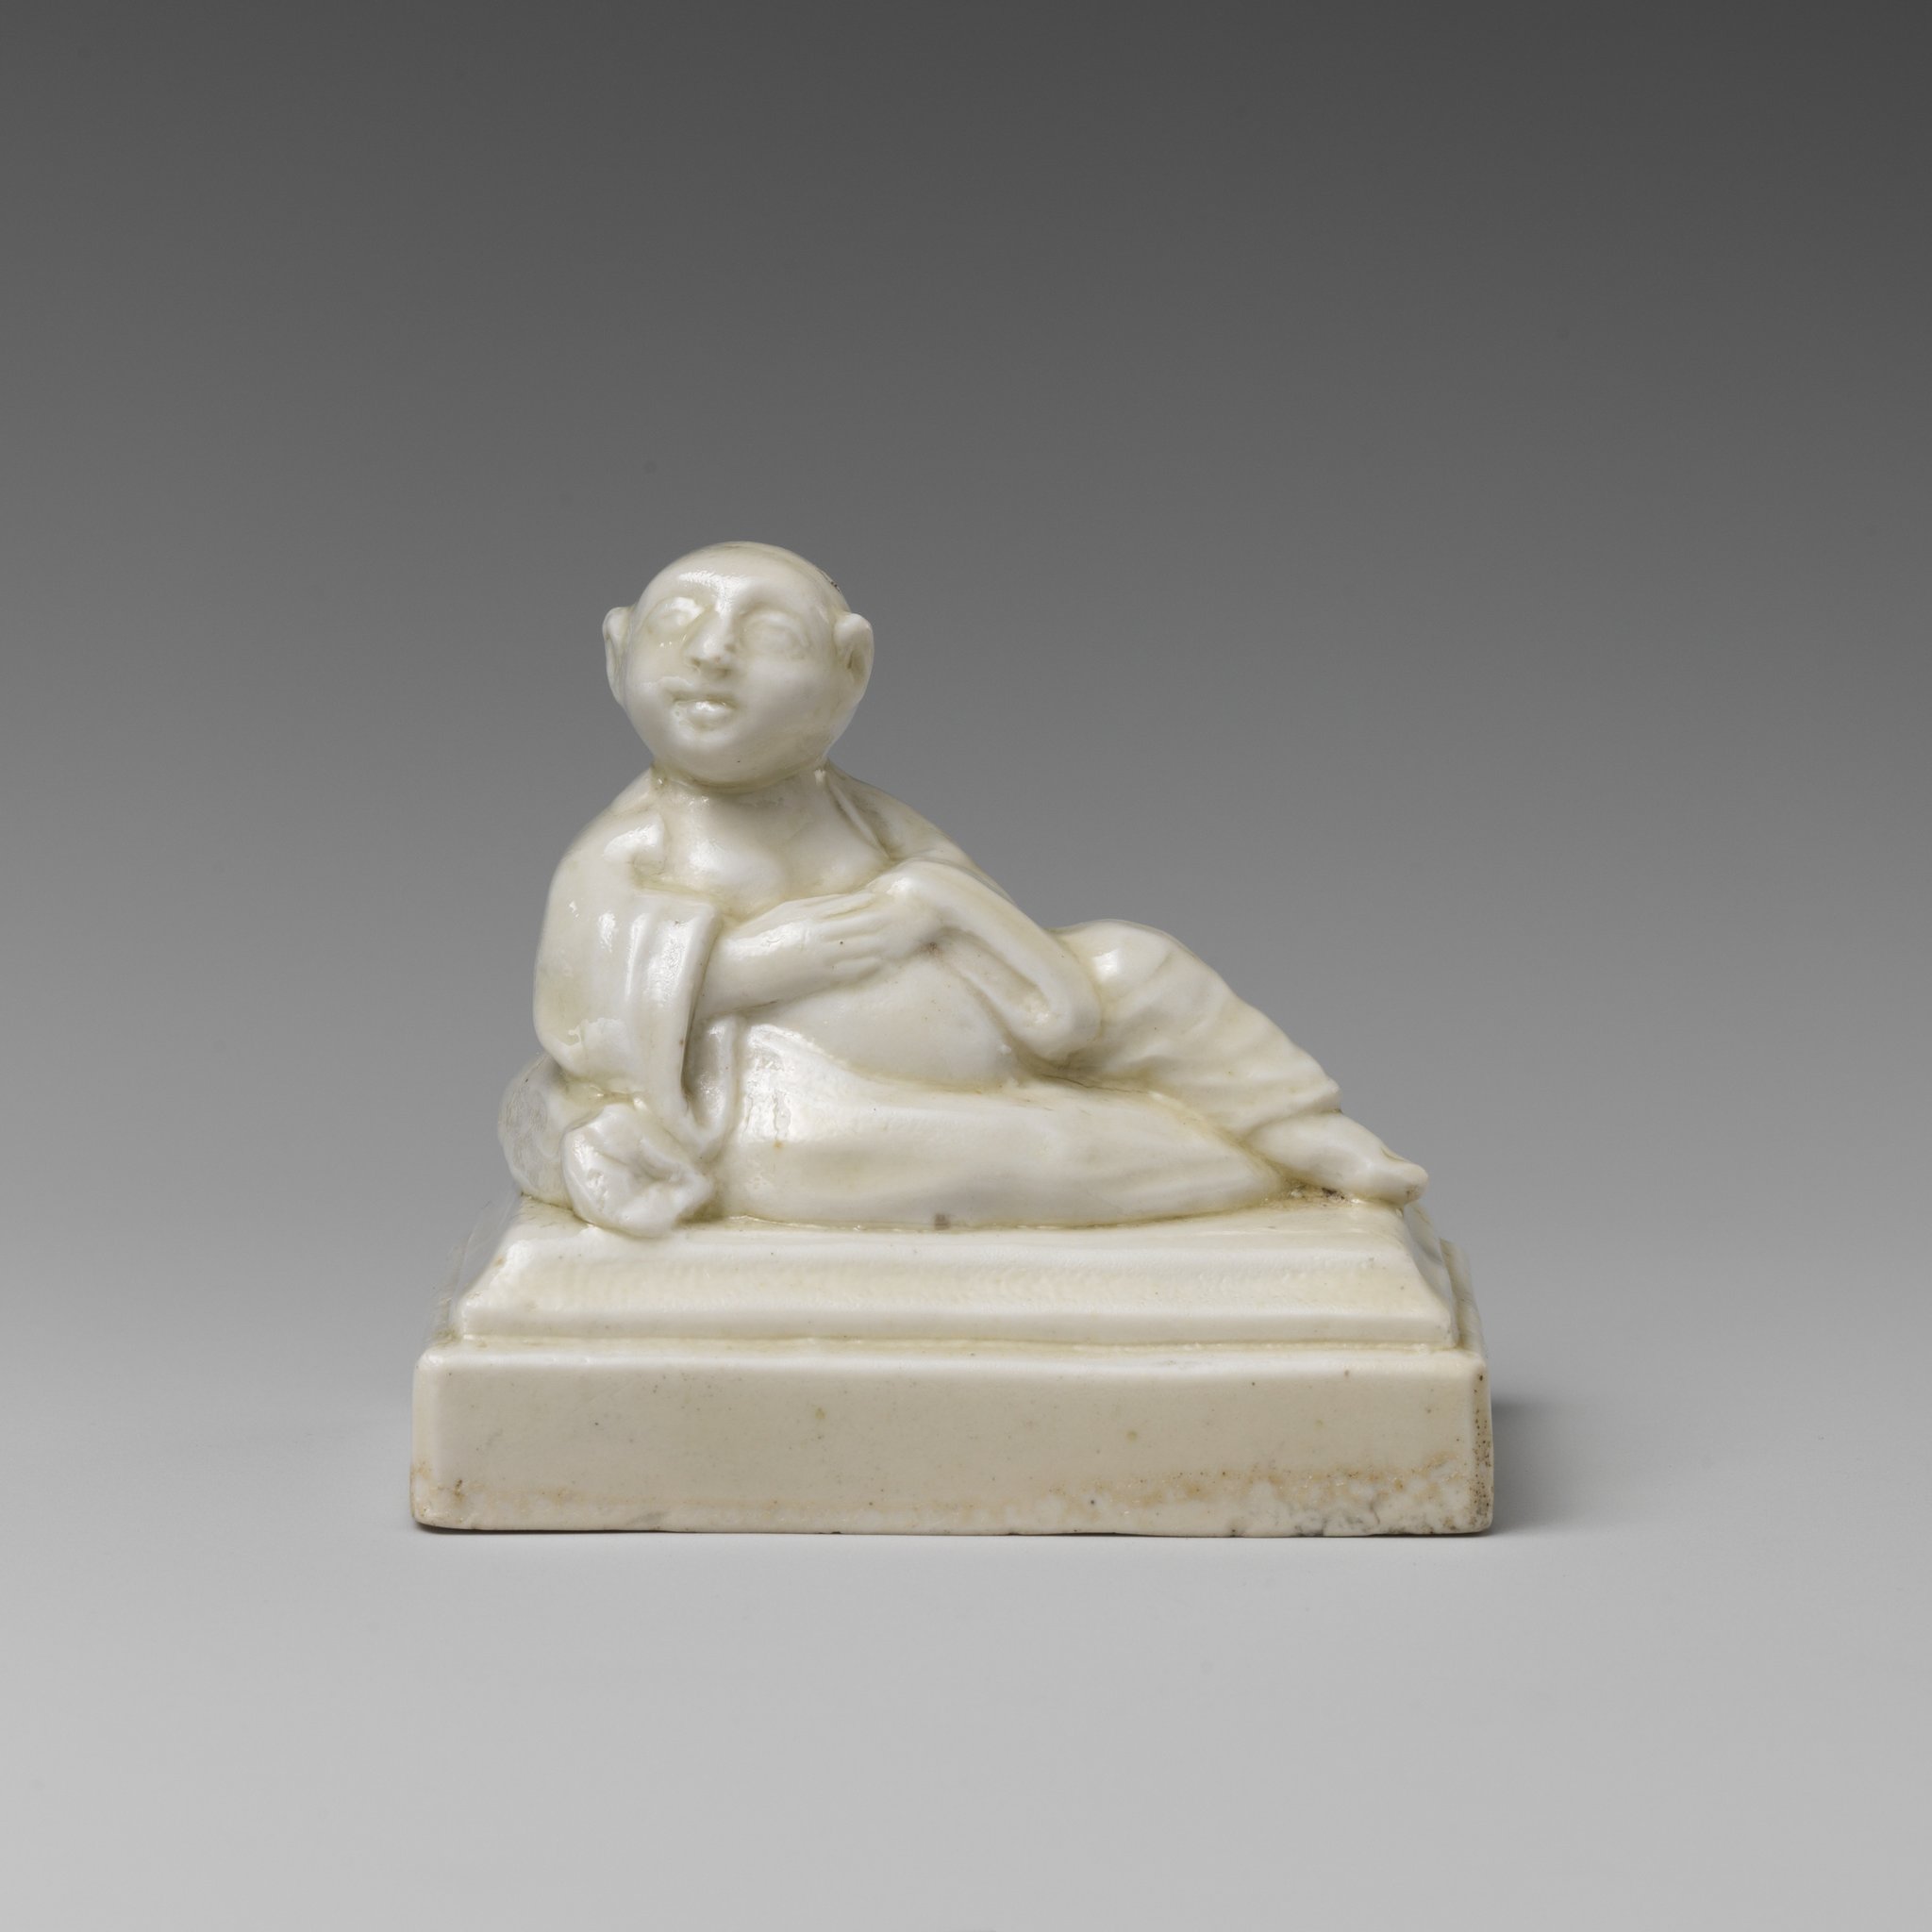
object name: figure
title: Chinese sage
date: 1720-1740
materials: soft paste porcelain